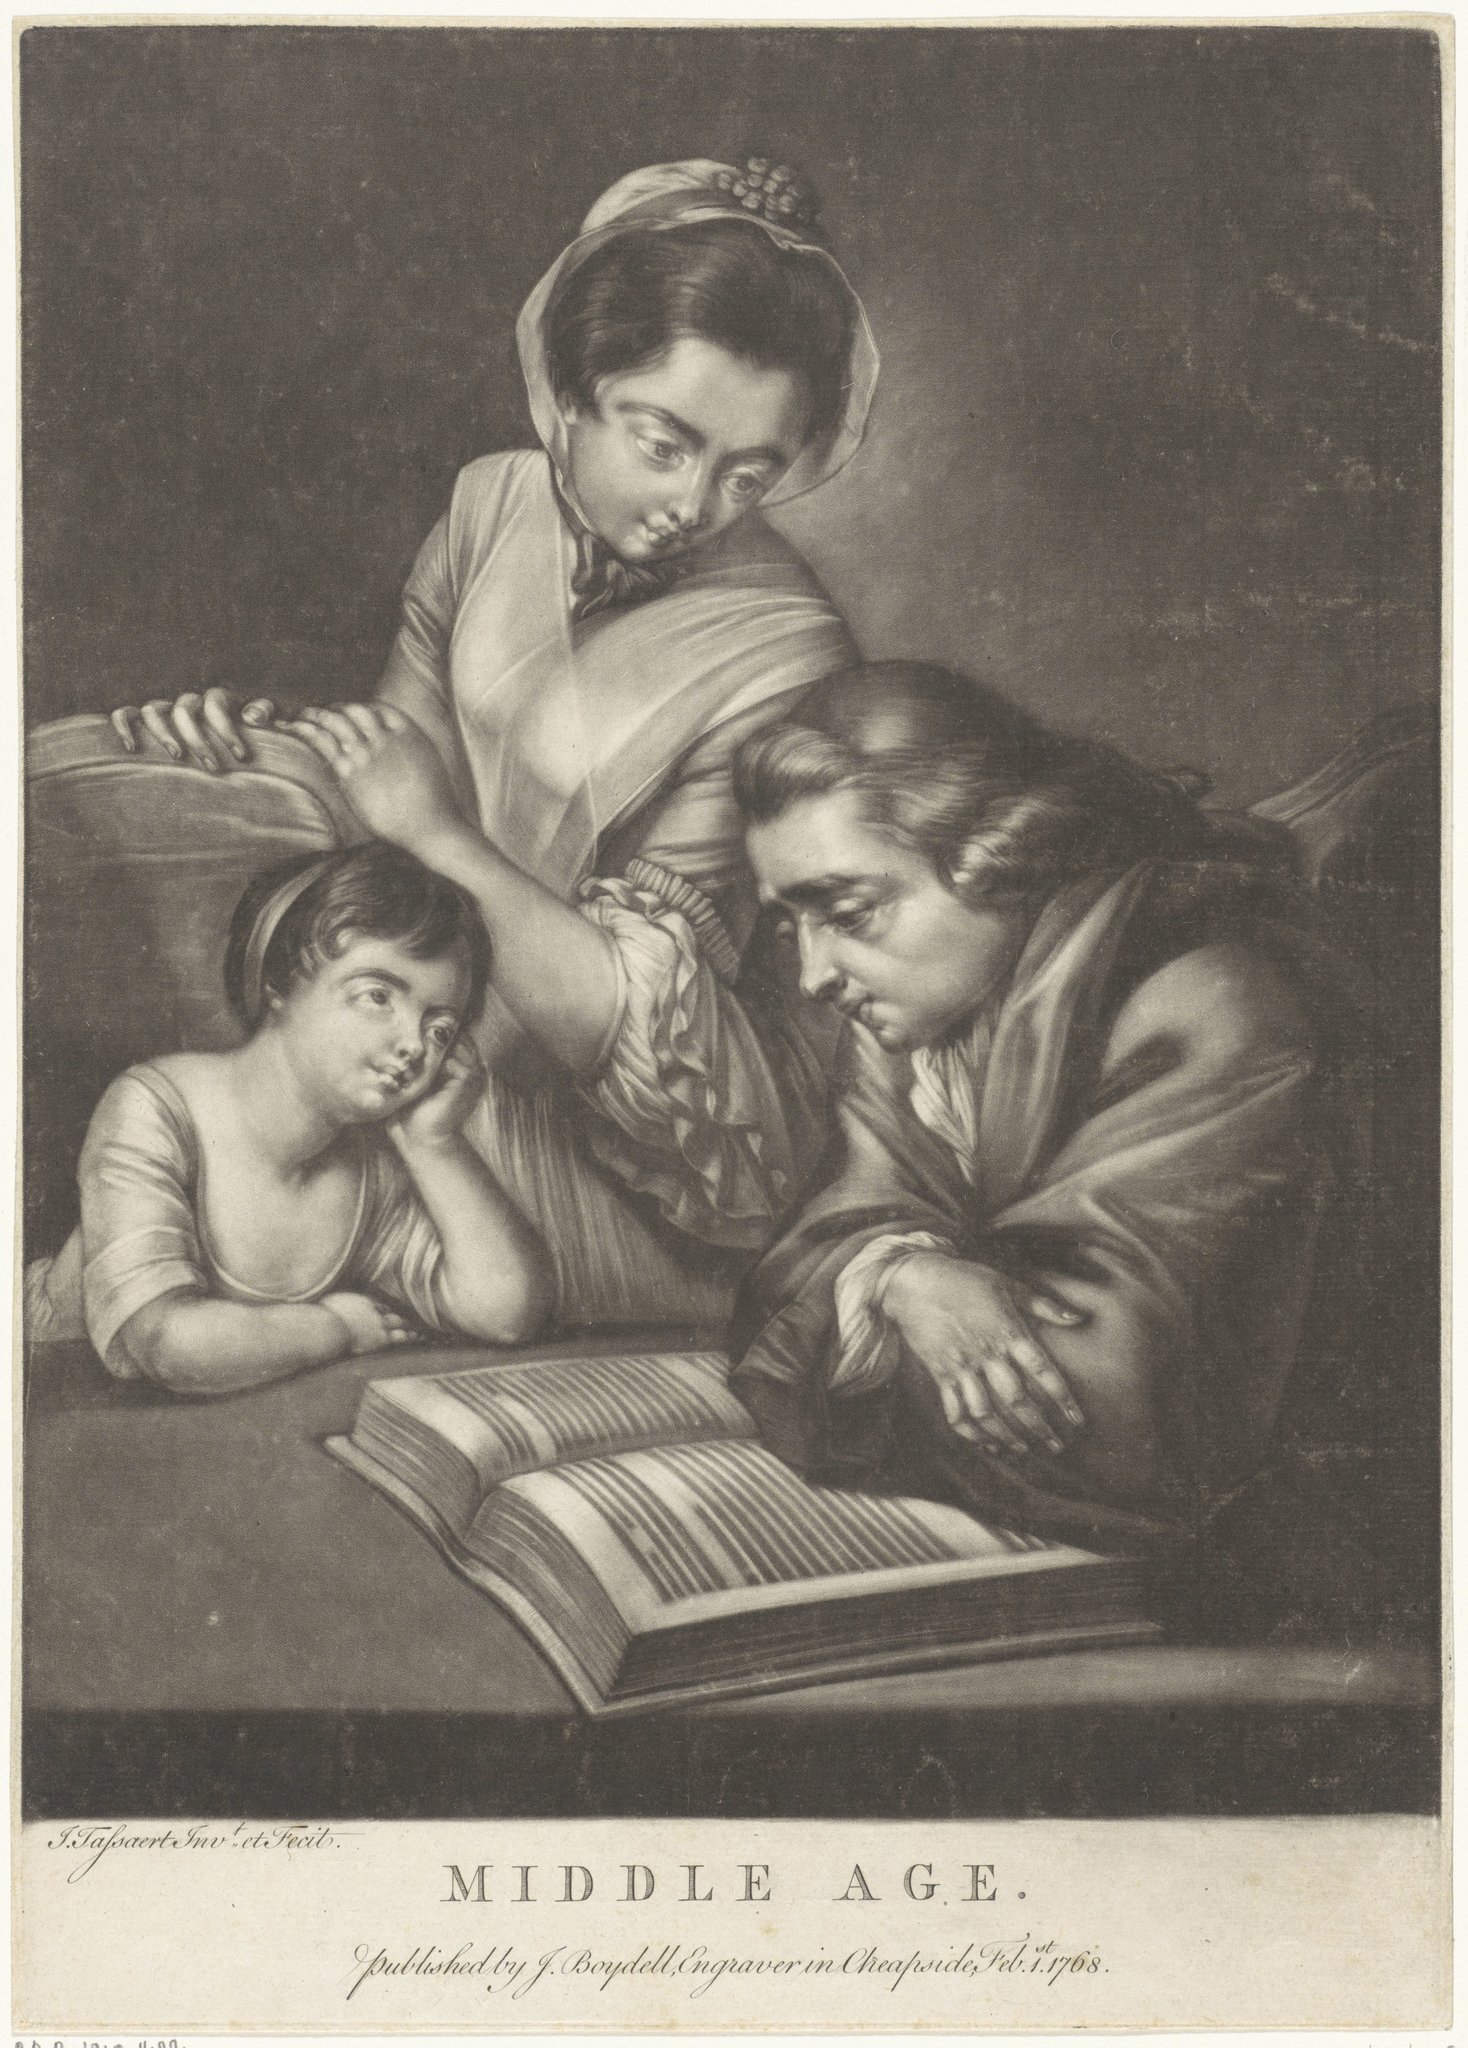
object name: print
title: De volwassenheid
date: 1768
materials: paper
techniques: engraving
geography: london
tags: the ages of man, book, reading to somebody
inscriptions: collector's mark: Lugt 2228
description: Aan een tafel leest een man een kind voor uit een boek. Bij het kind staat een vrouw. De prent is onderdeel van een reeks van vier prenten over de leeftijden van de mens.